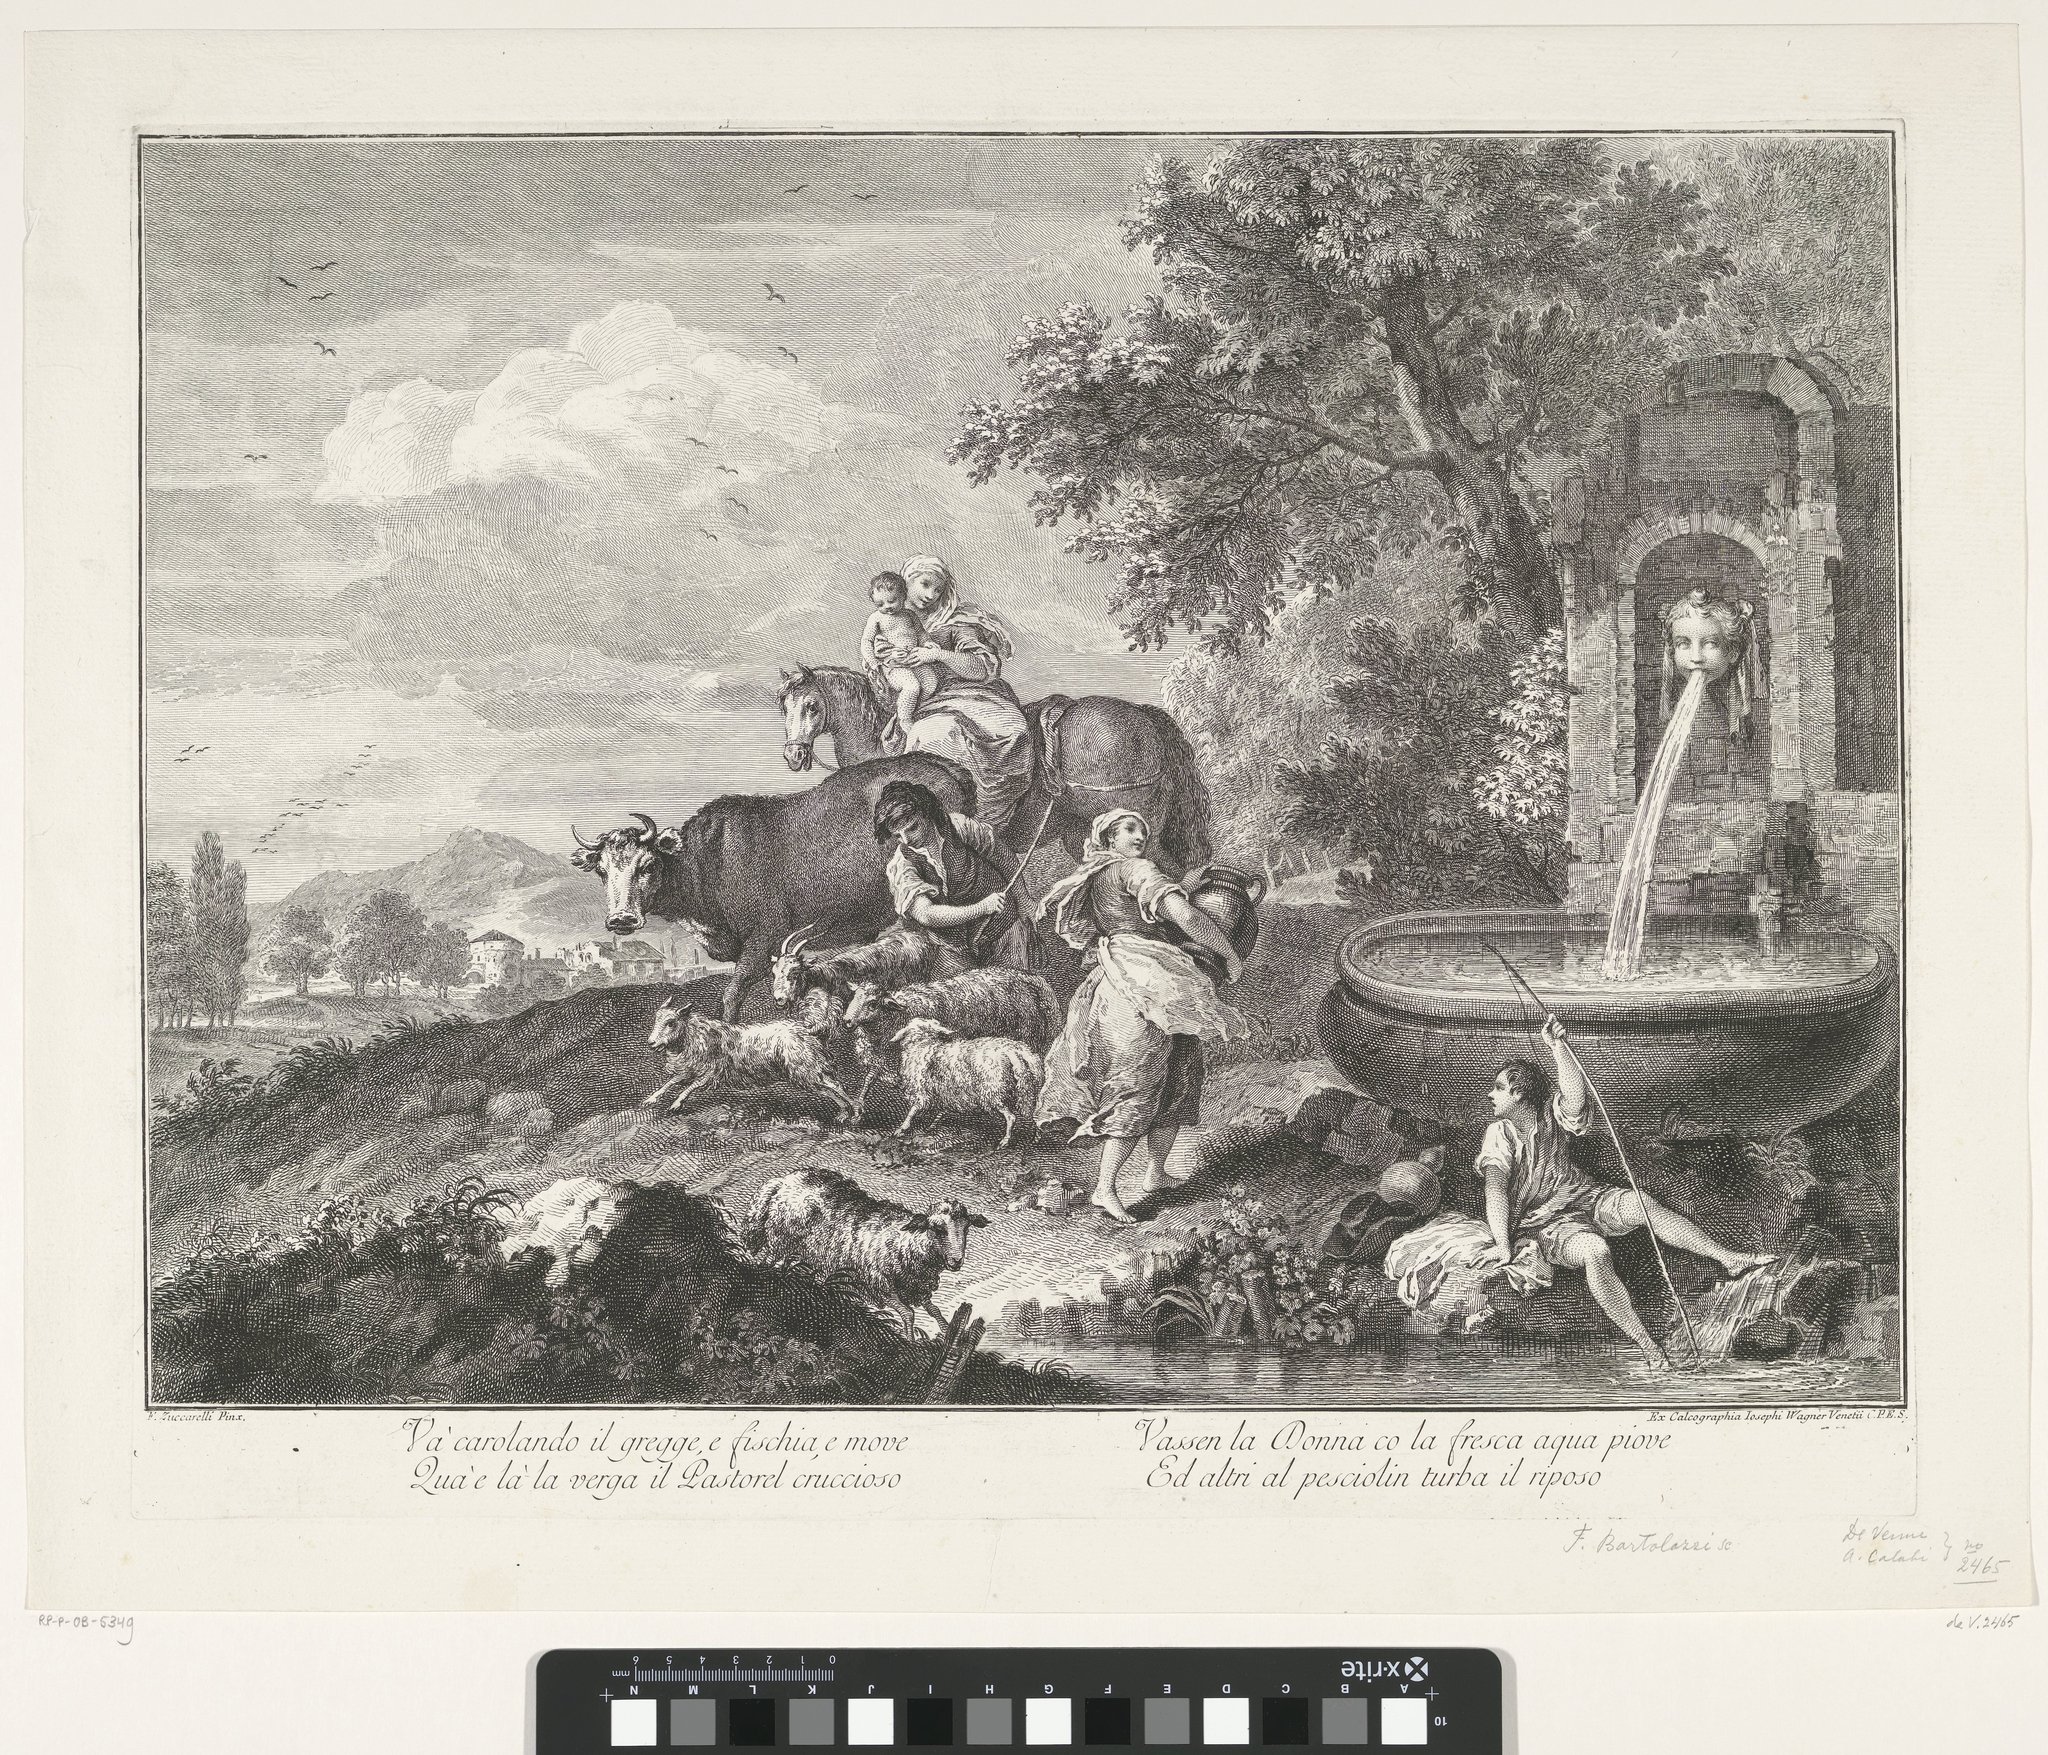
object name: print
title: Landschappen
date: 1762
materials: paper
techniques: engraving, etching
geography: venice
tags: city-view, and landscape with man-made constructions, herding, herdsman, herdswoman, shepherd, shepherdess, cowherd, etc., ornamental fountain, herd, flock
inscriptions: collector's mark: Lugt 240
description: Een landschap met een herder bij een kudde schapen, geiten en een os, een vrouw met kind te paard, een vrouw met een waterkruik en een jongen met een vishengel bij een waterbassin. Italiaans vers in ondermarge.